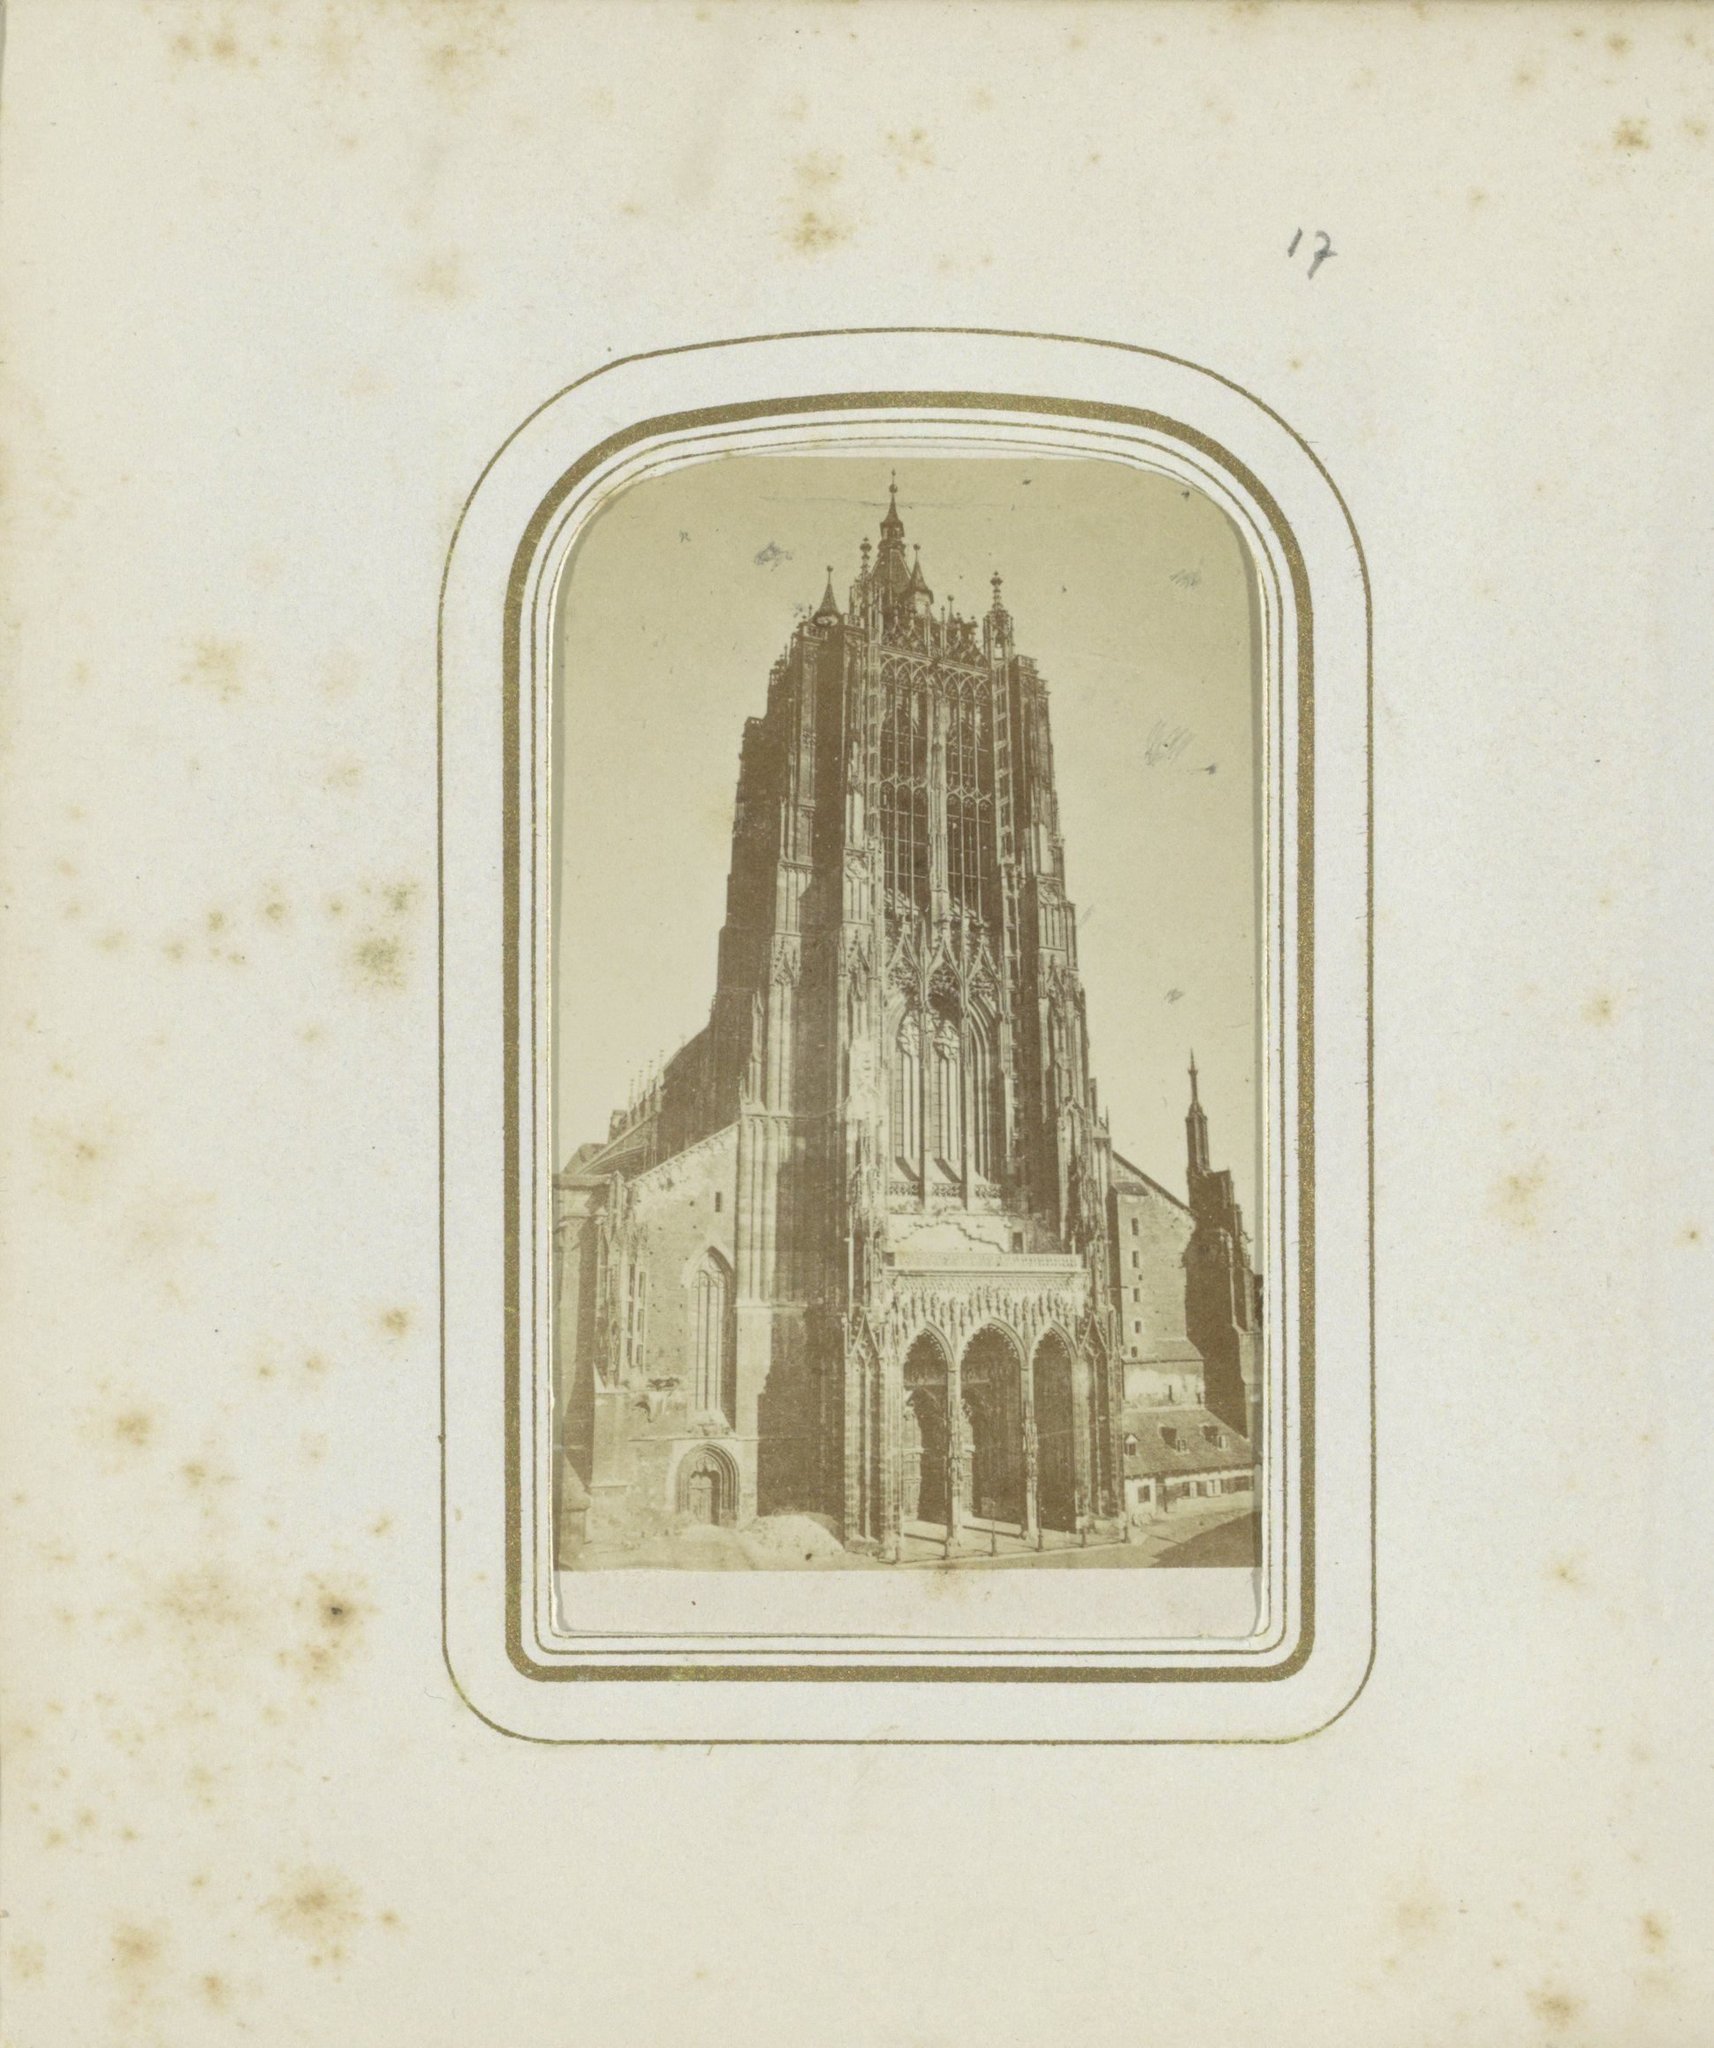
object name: photograph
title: Toren en ingang van de munsterkerk van Ulm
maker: Anonymous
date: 1865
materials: paper, photographic support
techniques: albumen print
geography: ulm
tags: gate, entrance, travelling; tourism, parts of church exterior and annexes: tower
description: Onderdeel van Fotoalbum van een reis door Zwitserland, Oostenrijk en Duitsland door de Nederlandse familie Derkinderen.